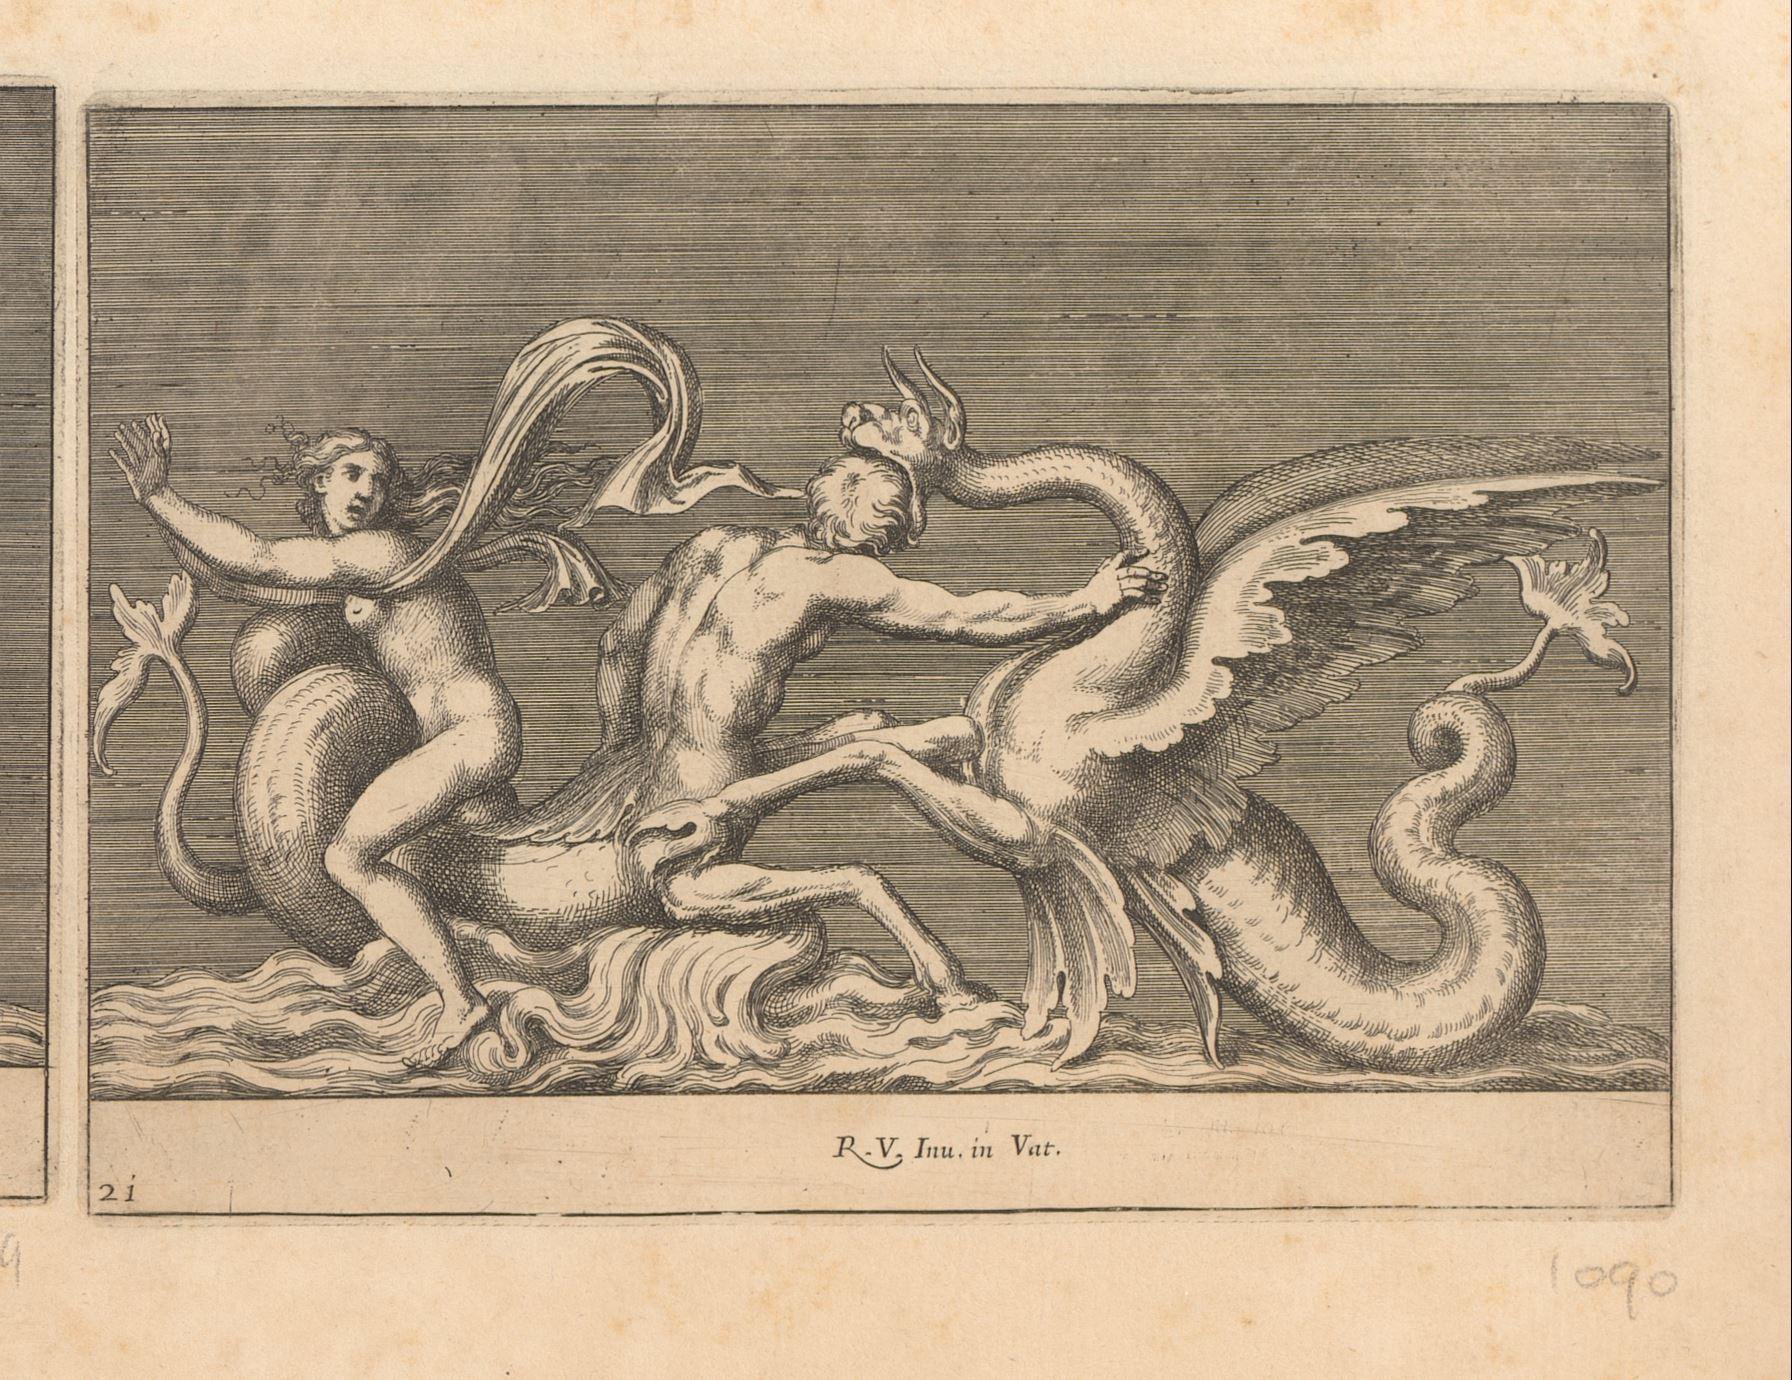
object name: print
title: Triton in gevecht met een zeemonster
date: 1645-1700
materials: paper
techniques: engraving, etching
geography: italy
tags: triton(s), monsters of the sea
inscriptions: number: ‘46’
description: Een triton, met een naakte vrouwenfiguur op zijn rug, in gevecht met een zeemonster. Prent maakt deel uit van een album.